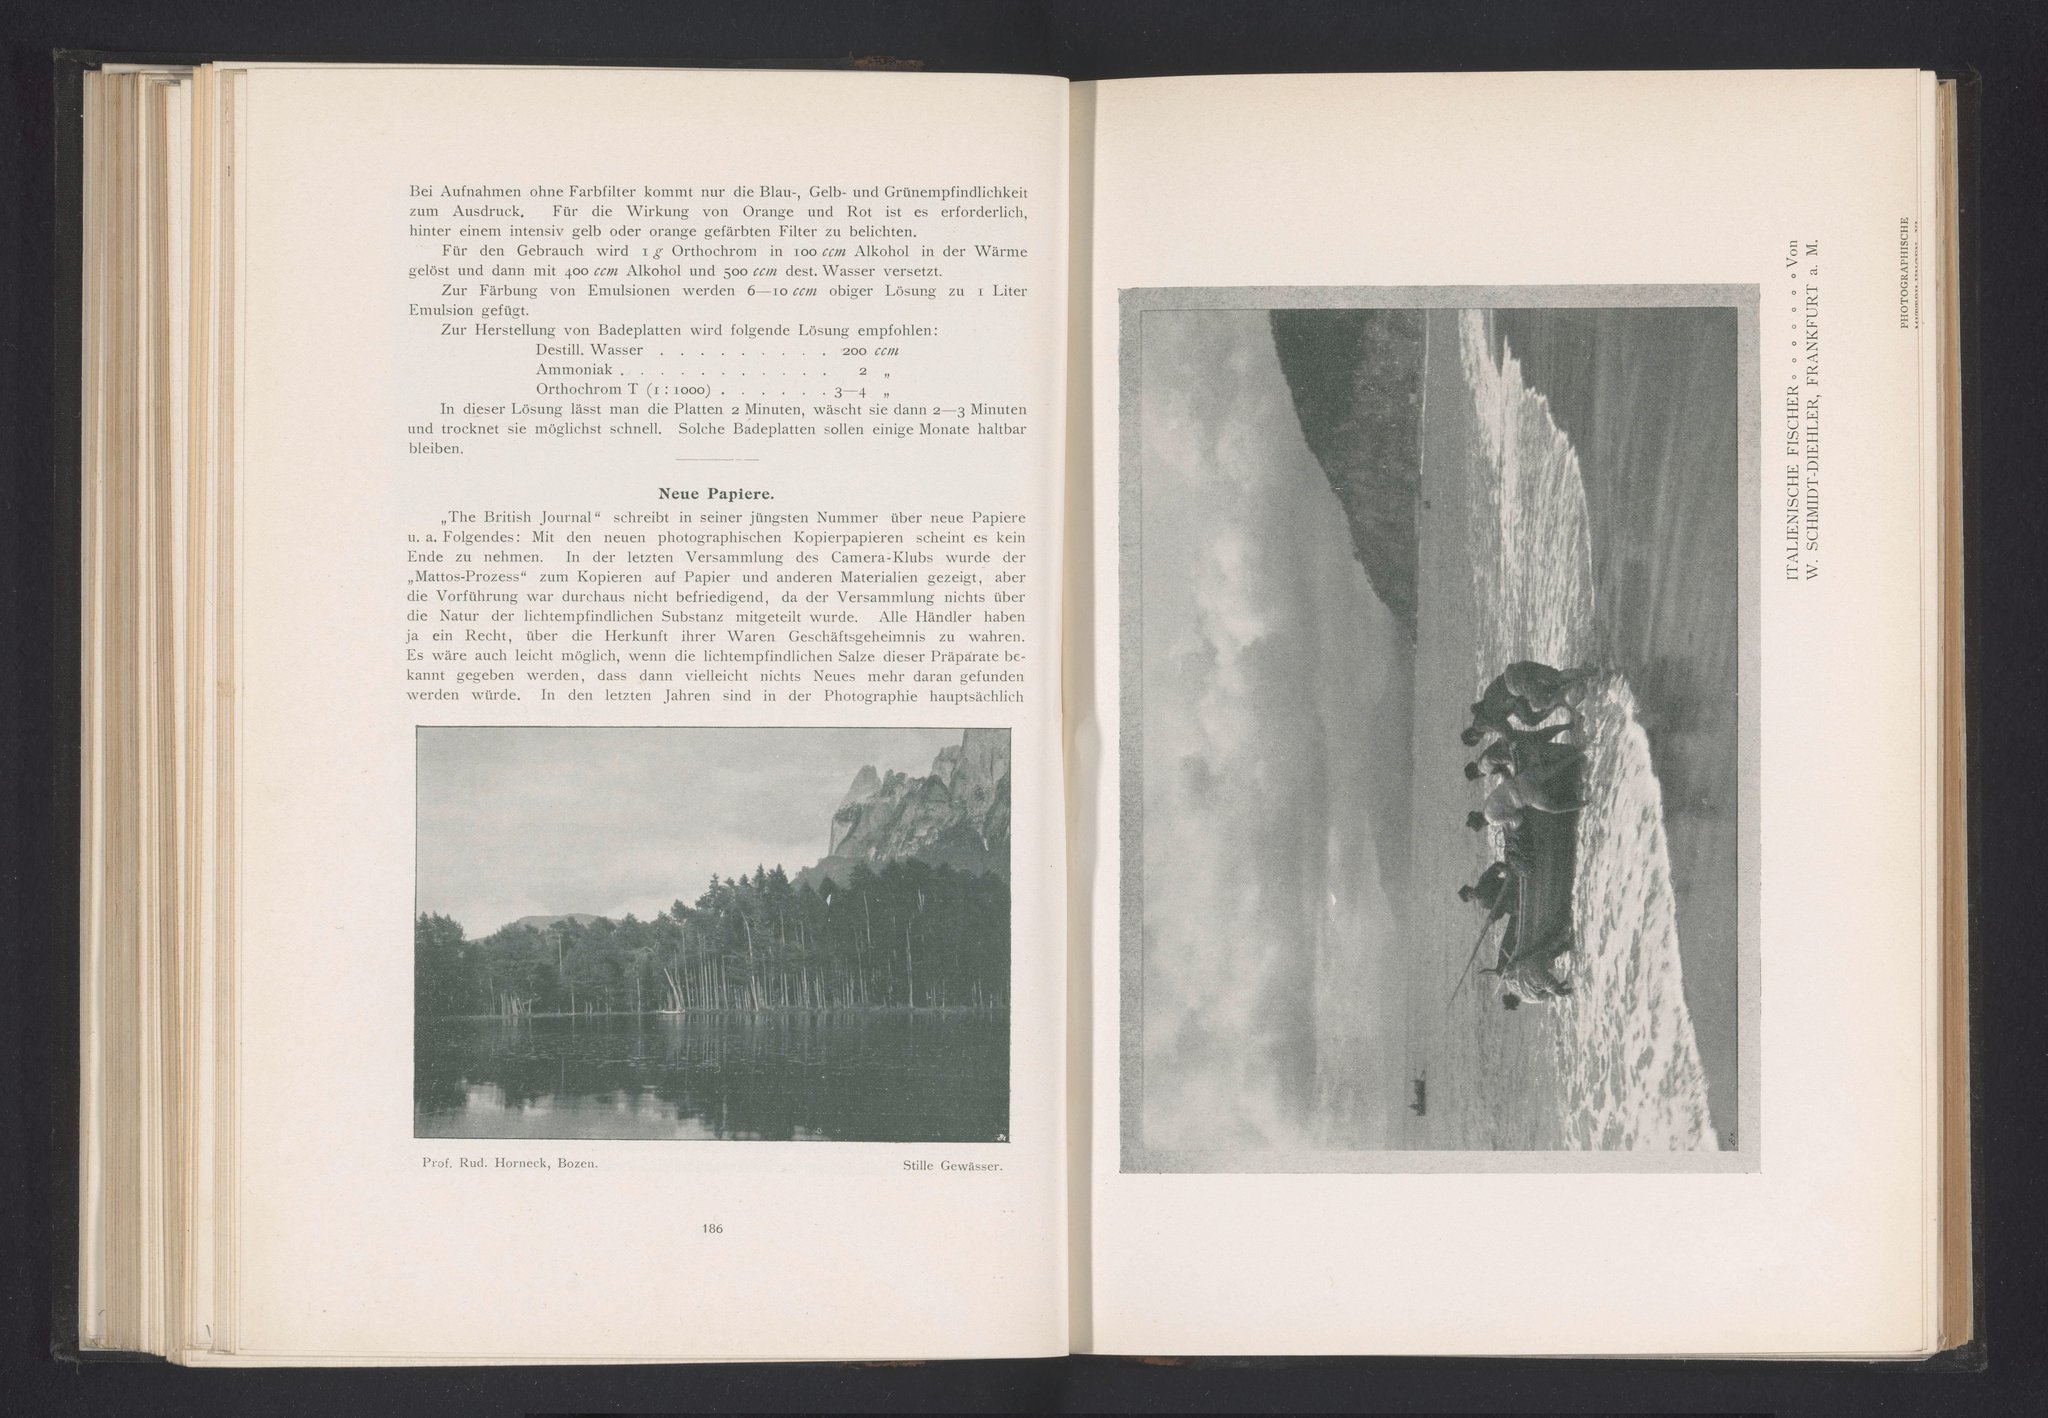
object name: photomechanical print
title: Zeegezicht met vissers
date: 1898-1903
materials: paper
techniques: autotype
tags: sea (seascape), fisherman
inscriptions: monogram: ‘BX’